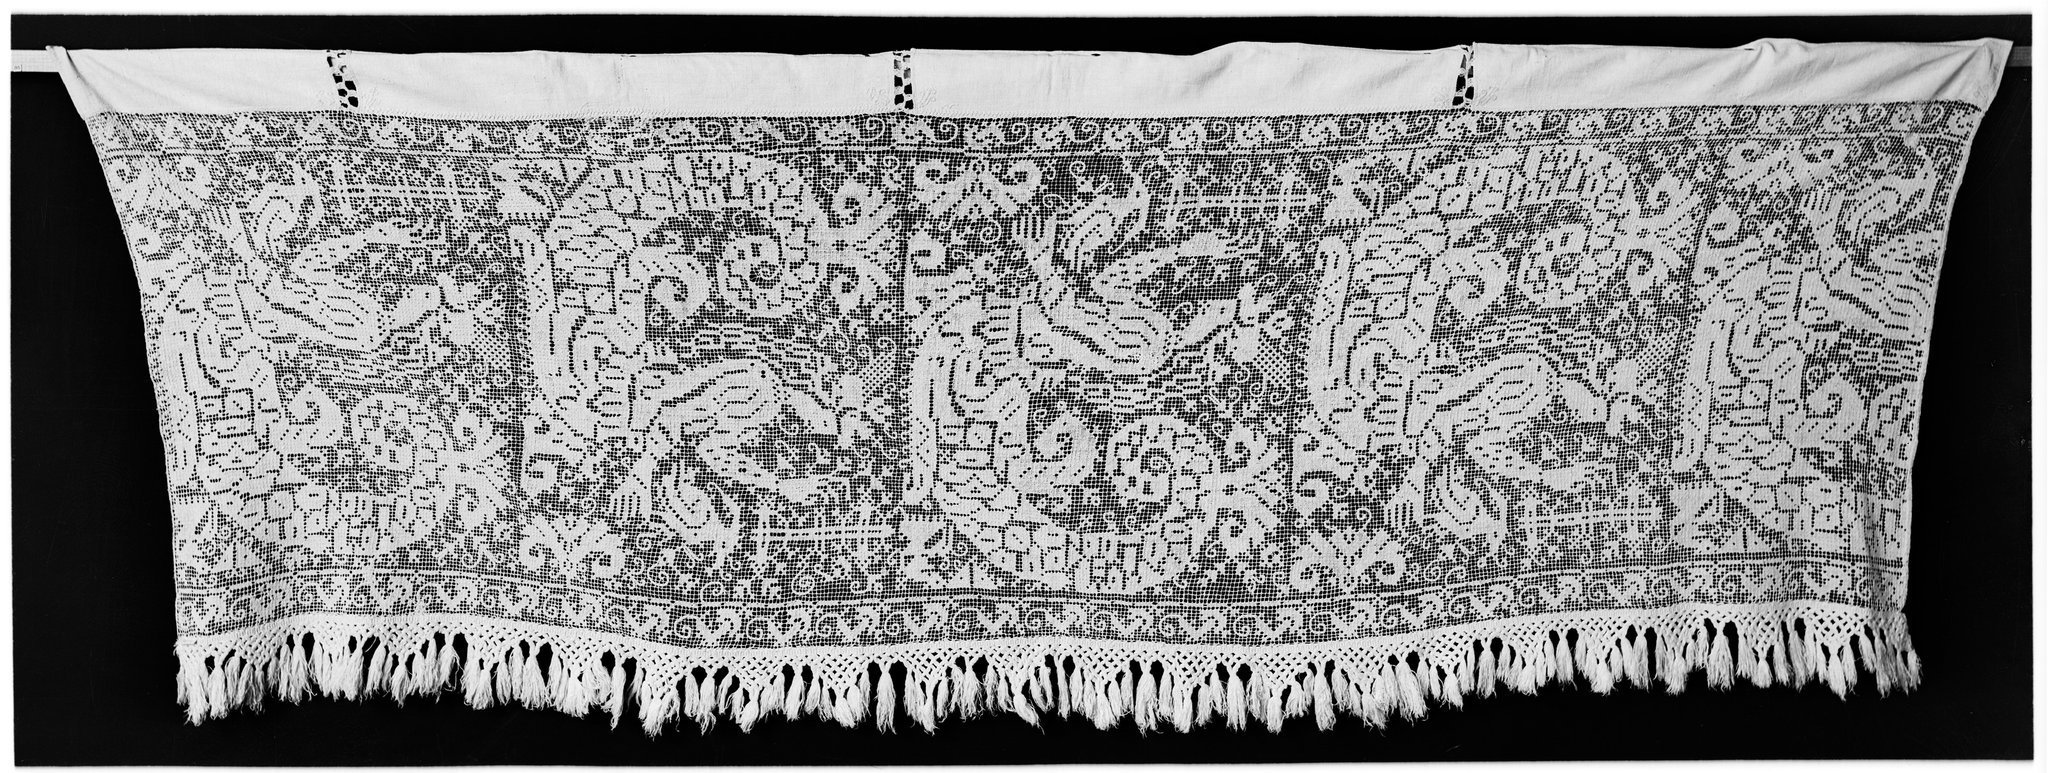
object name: hanging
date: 1501-1533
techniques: embroidery